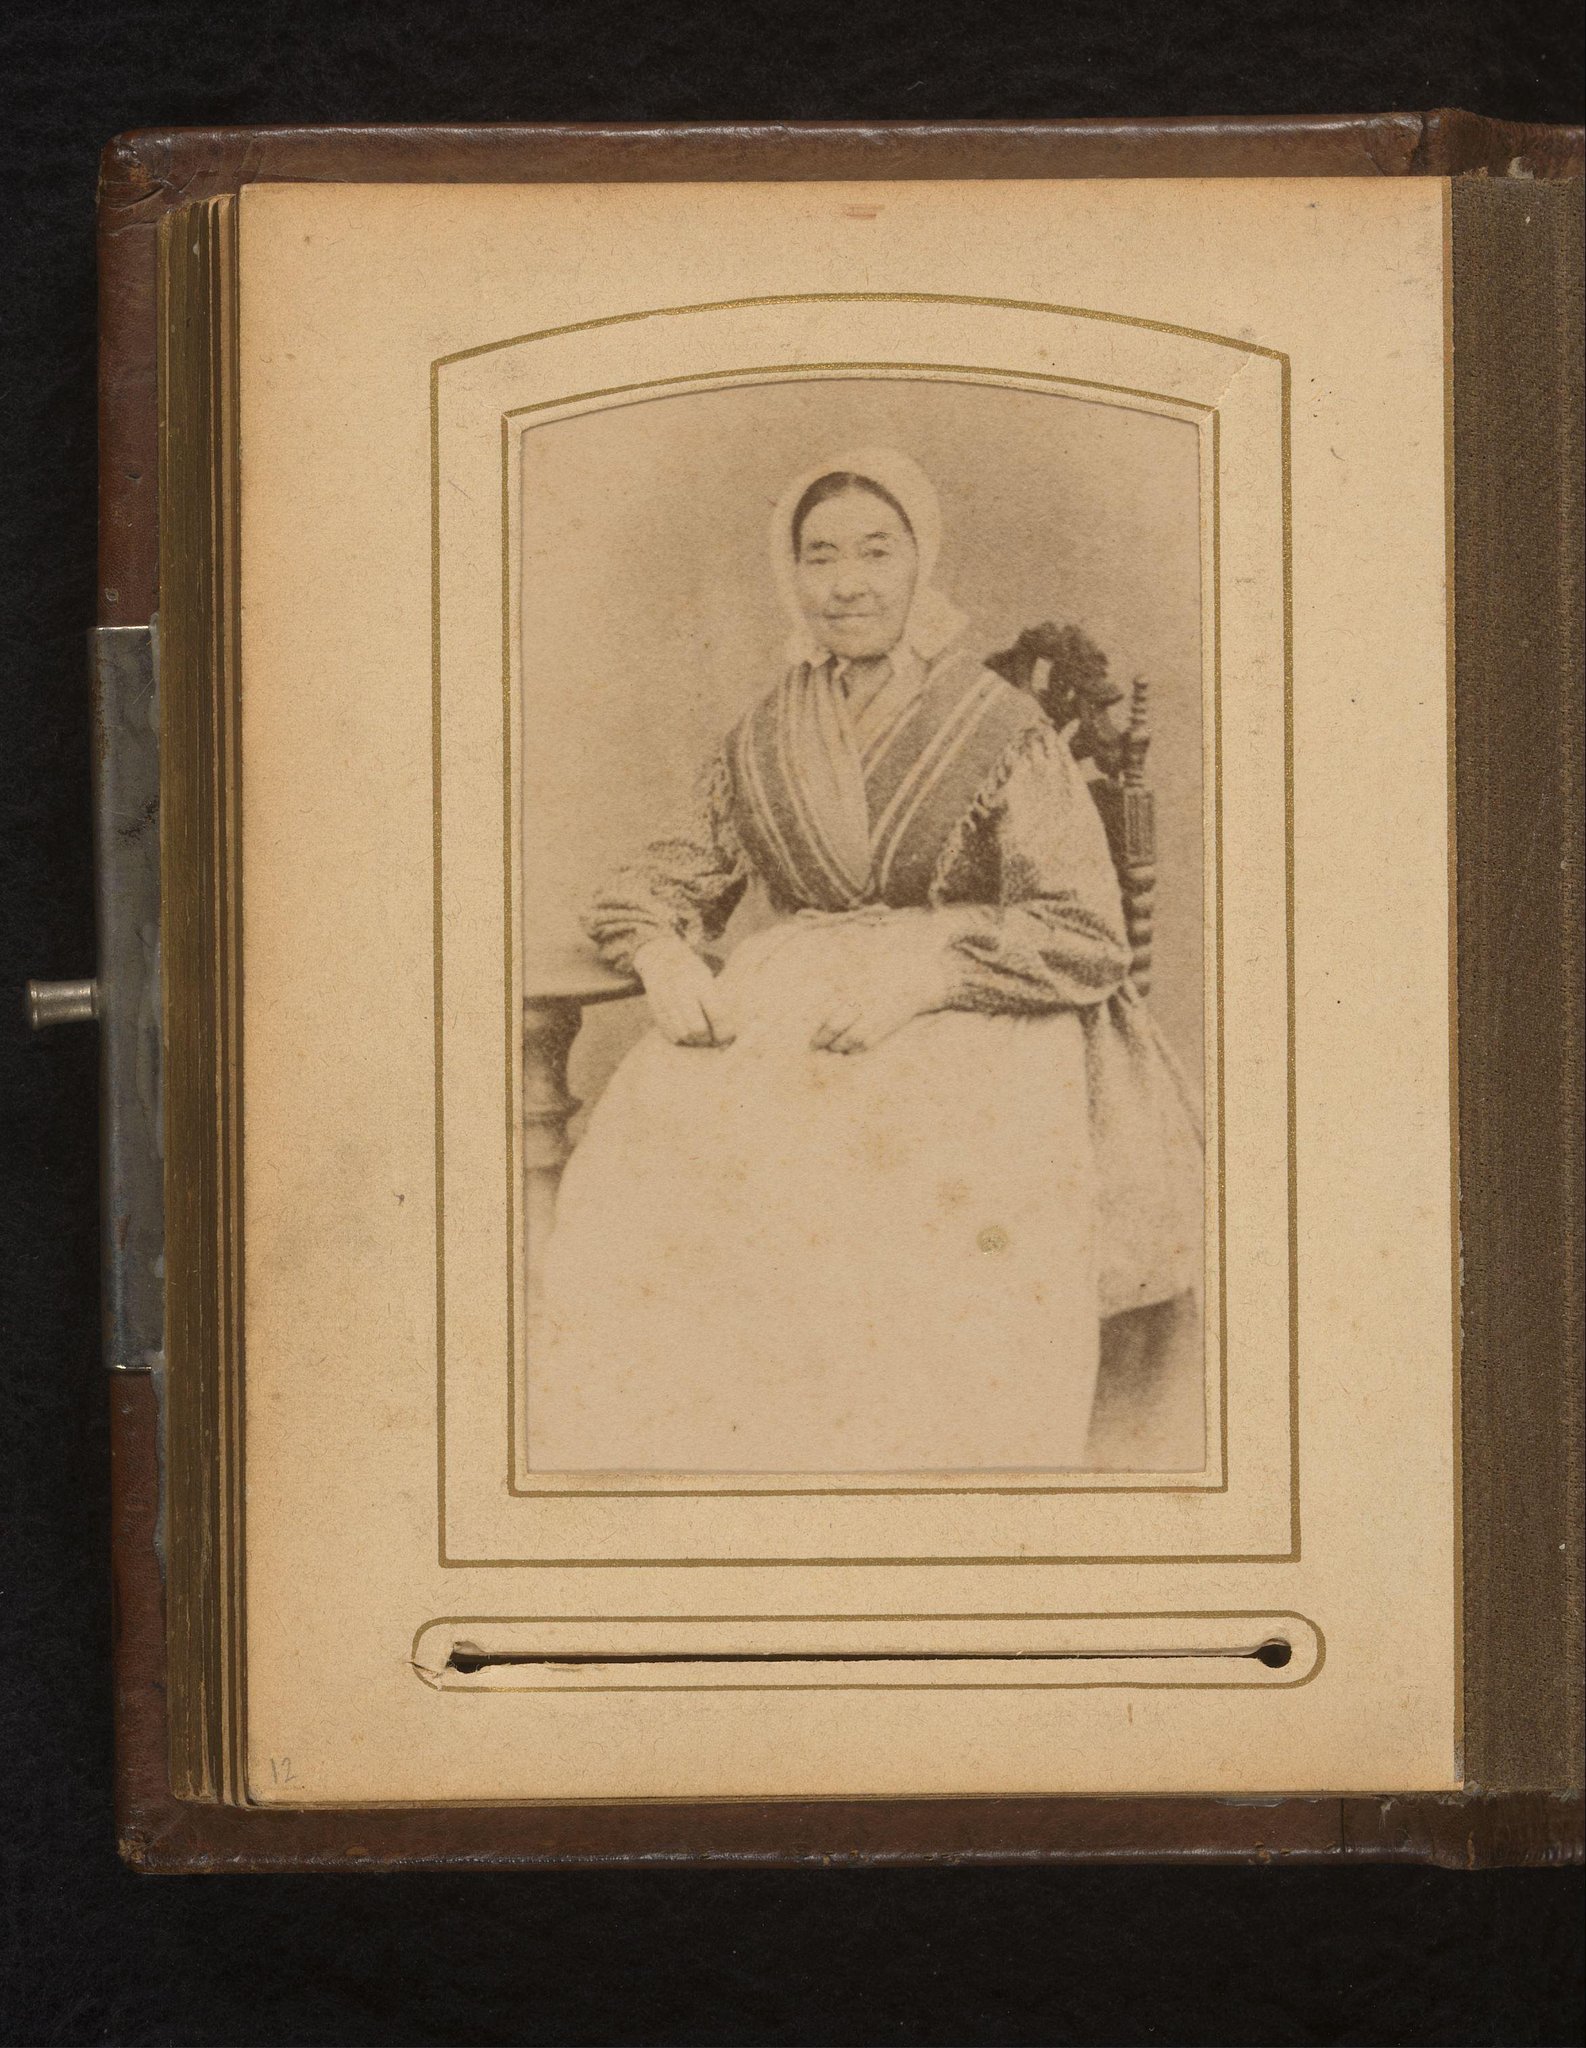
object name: album leaf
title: Portret van vrouw, zittend op een stoel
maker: broekhuizen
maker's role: fotograaf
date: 1860-1900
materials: cardboard, photographic support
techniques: albumen print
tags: sitting figure, adult woman, historical persons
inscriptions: inscription: ‘Broekhuizen/ Photograaf/ Gouwe 81, Gouda/ Lage Prijzen’